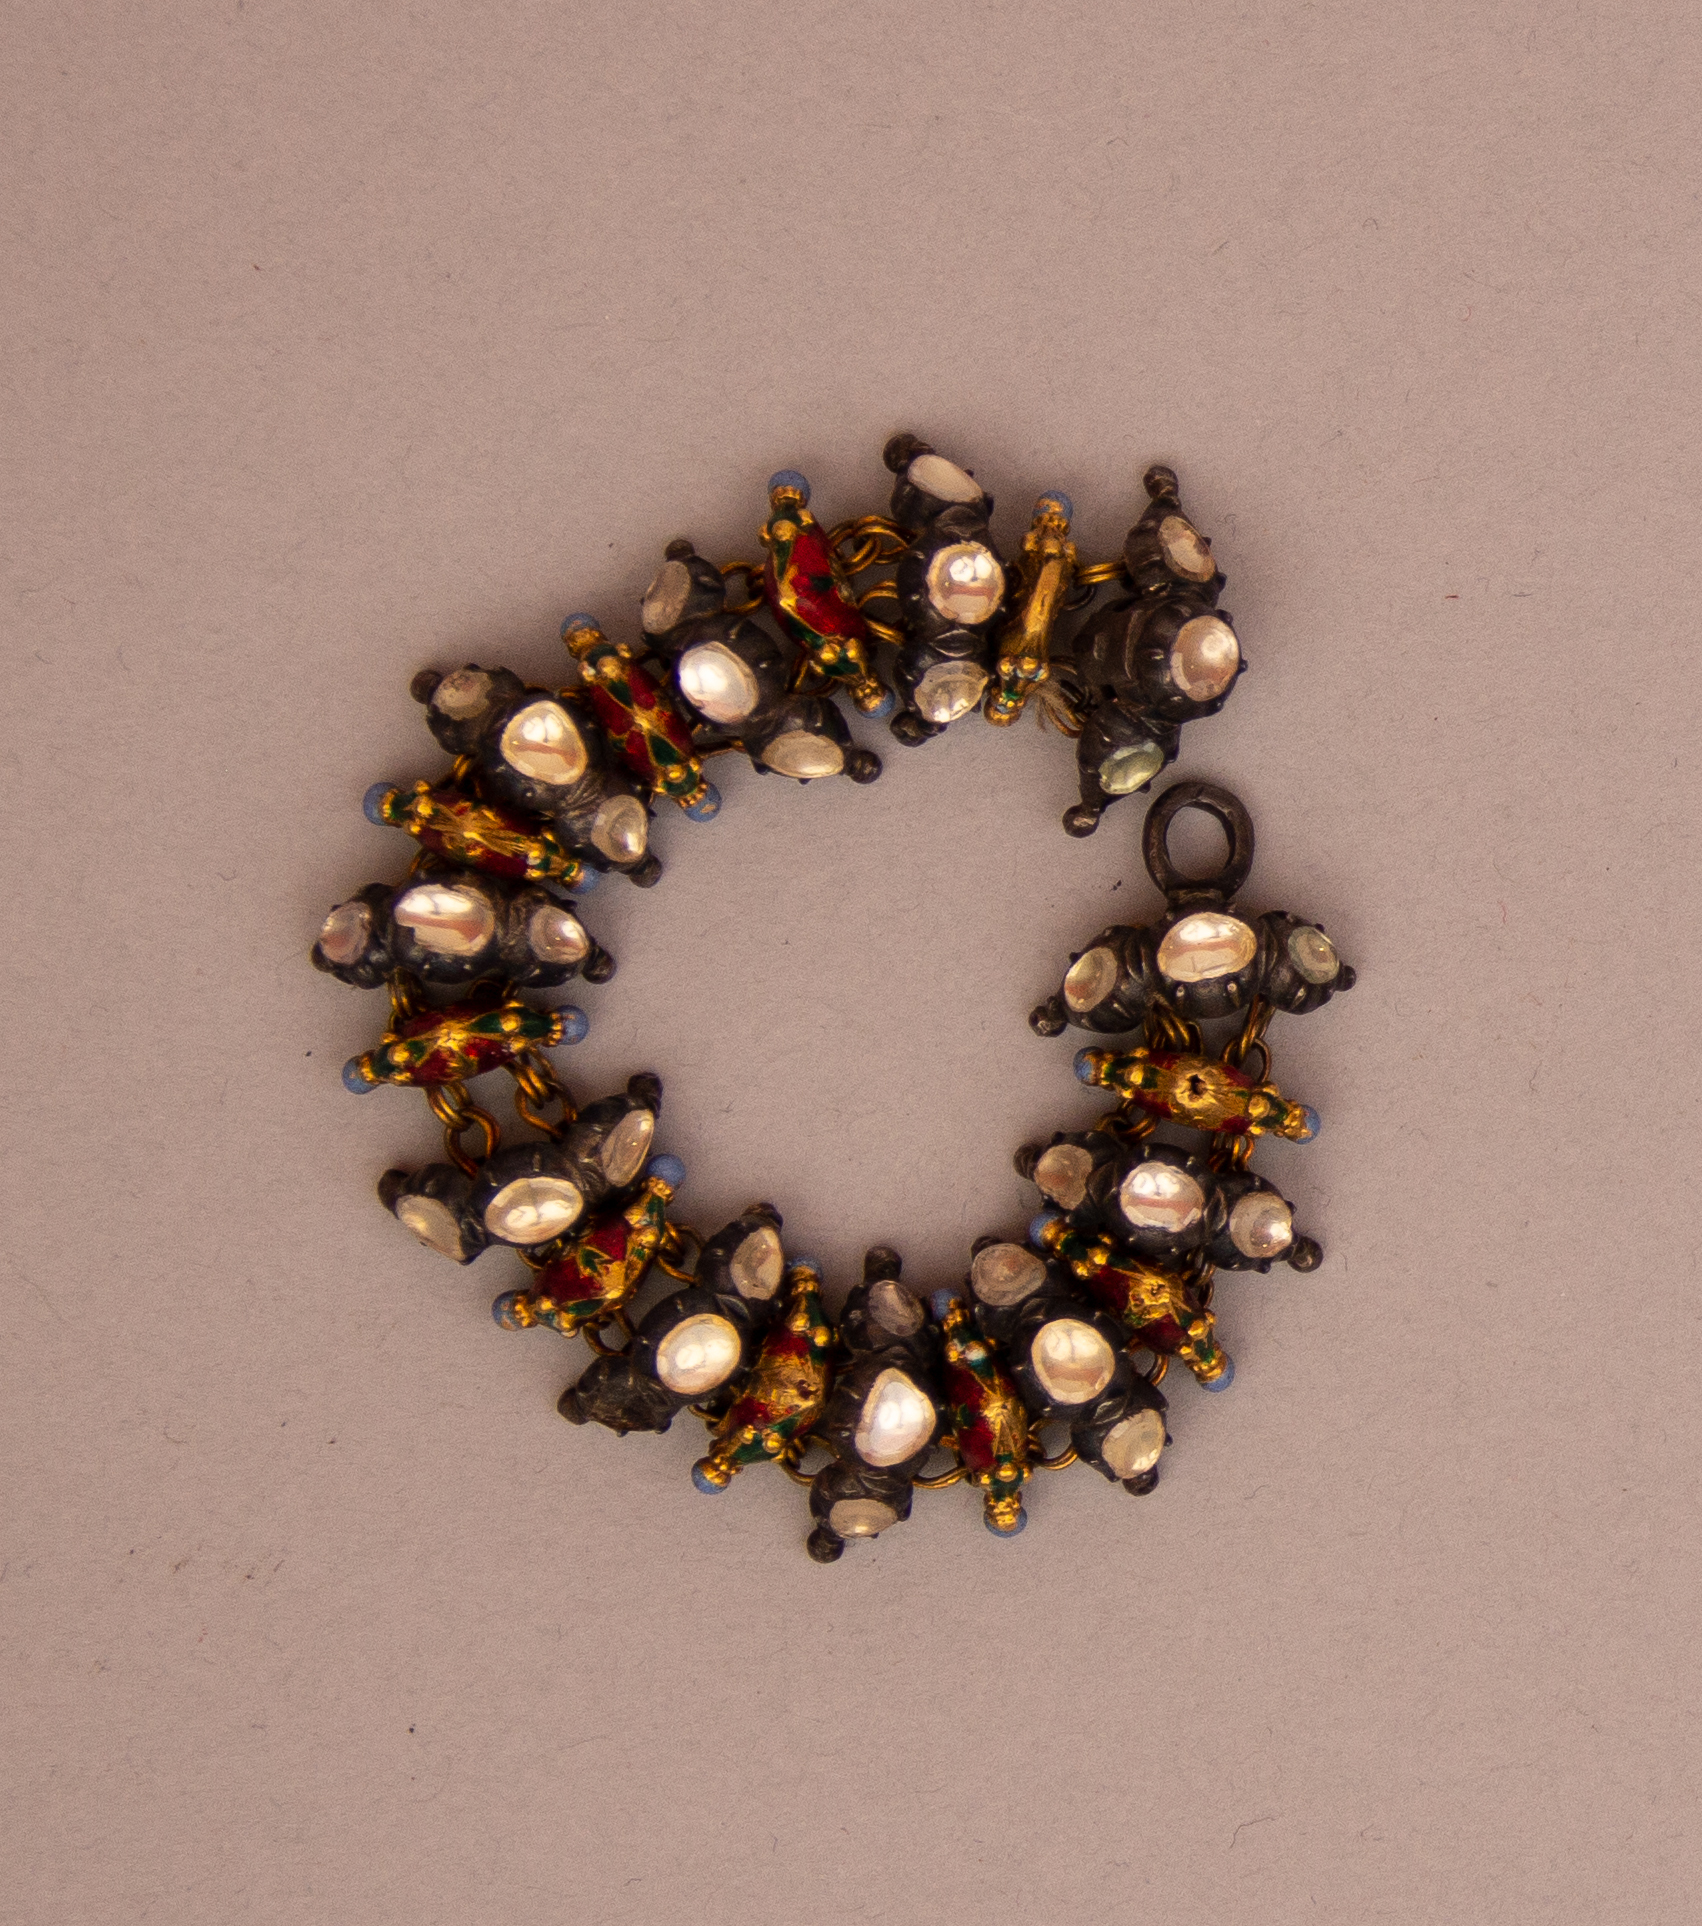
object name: bracelet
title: Bracelet, One of a Pair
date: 1601-1900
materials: gold, silver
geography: india